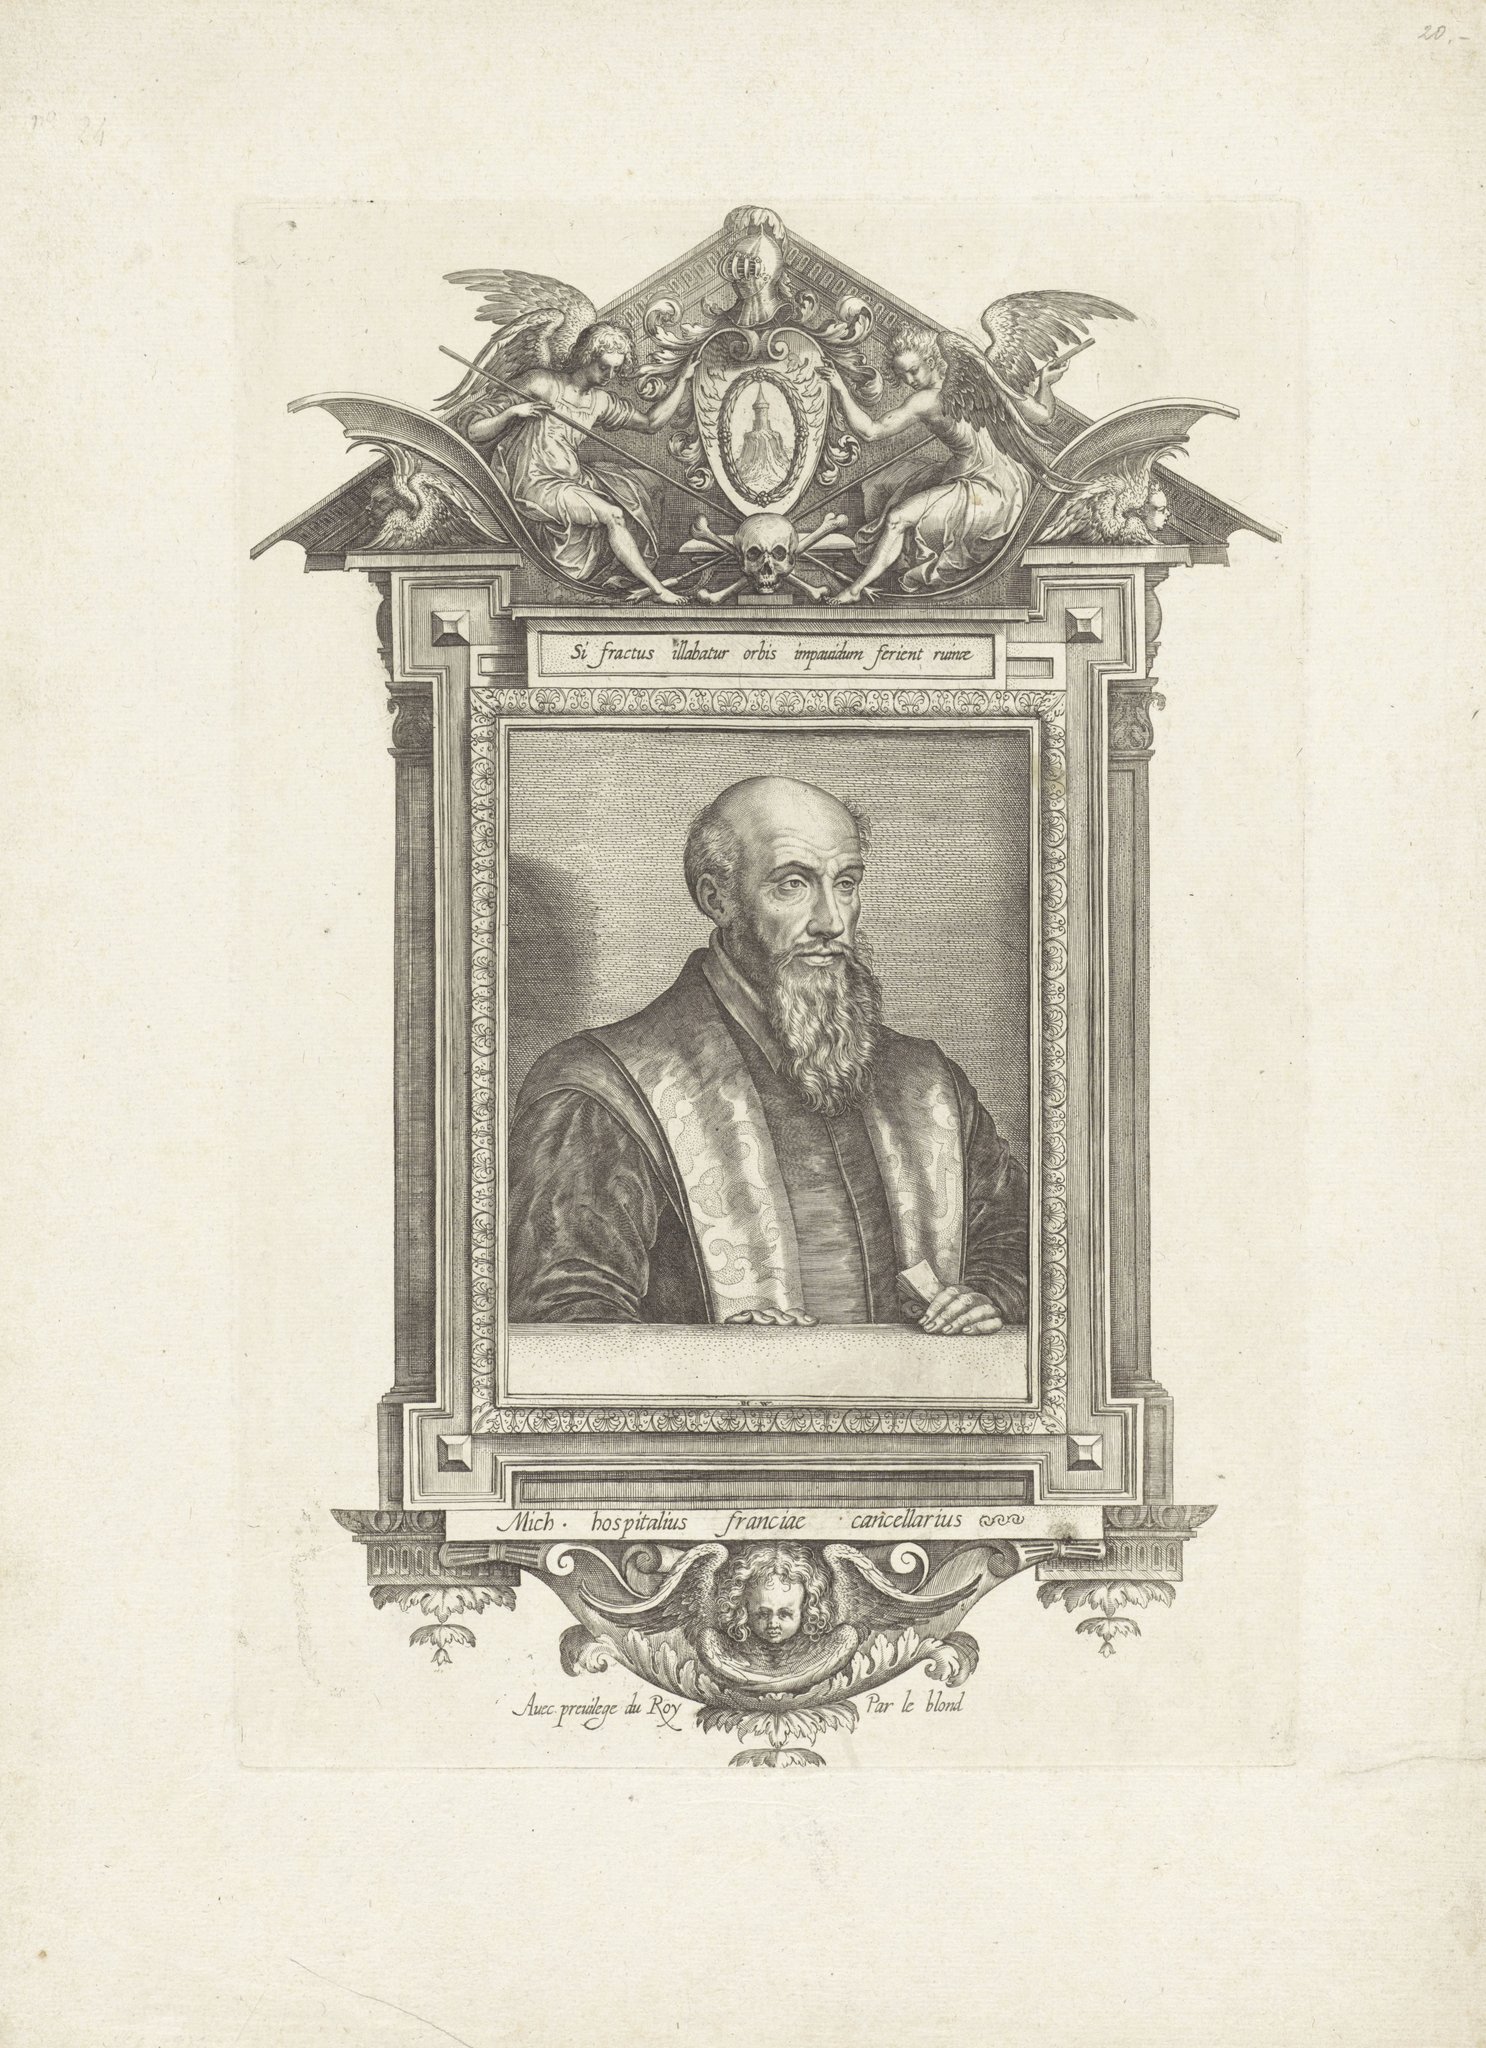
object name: print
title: Portret van Michel de L'Hospital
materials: paper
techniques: engraving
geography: antwerp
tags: monumental door, porch, 'aediculum', armorial bearing, heraldry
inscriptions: collector's mark: Lugt 2760, collector's mark: Lugt 2228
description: Het portret is gevat in de architecturale omlijsting van een aedicula. Bovenaan het wapenschild van de geportretteerde, geflankeerd door twee engelen. In het kader een opschrift in het Latijn.